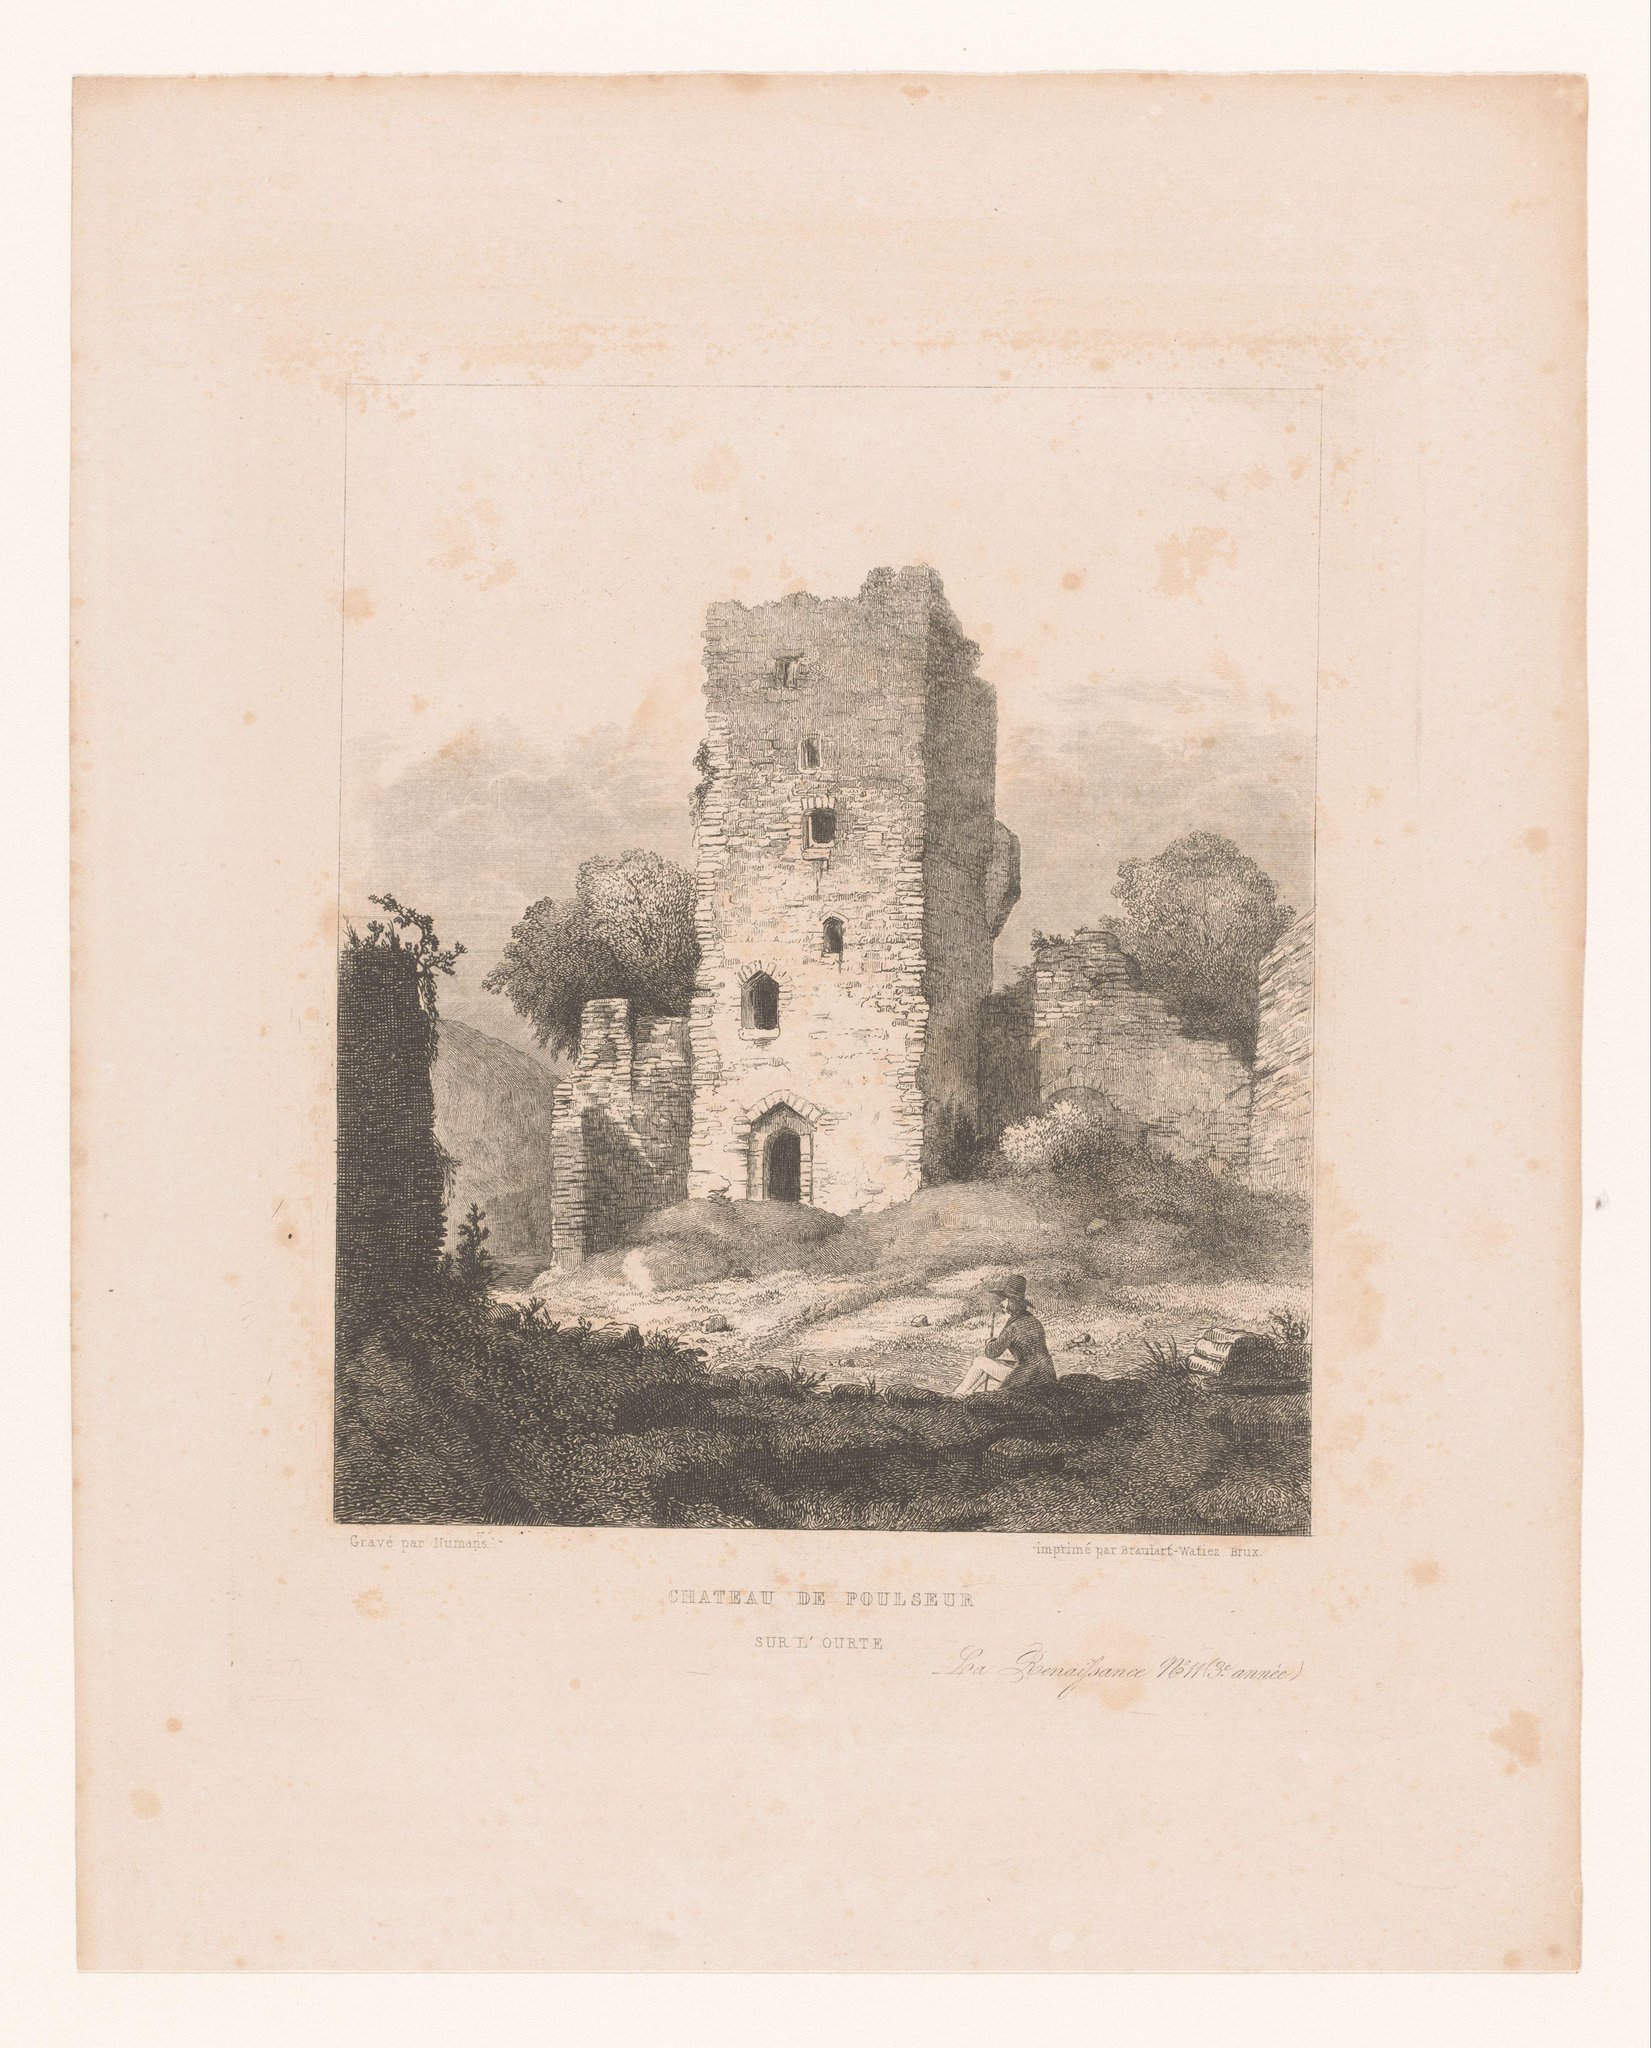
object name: print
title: Ruïnes van Chateau de Poulseur sur l'Ourte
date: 1833-1879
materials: paper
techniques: etching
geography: brussels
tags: landscape with ruins (+ city(-scape) with figures, staffage), ruin of a dwelling, house, castle, etc.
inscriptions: collector's mark: Lugt 2228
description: Prent uit: La Renaissance. Chronique des arts et de la littérature 3 (1841-1842), pl. 11.